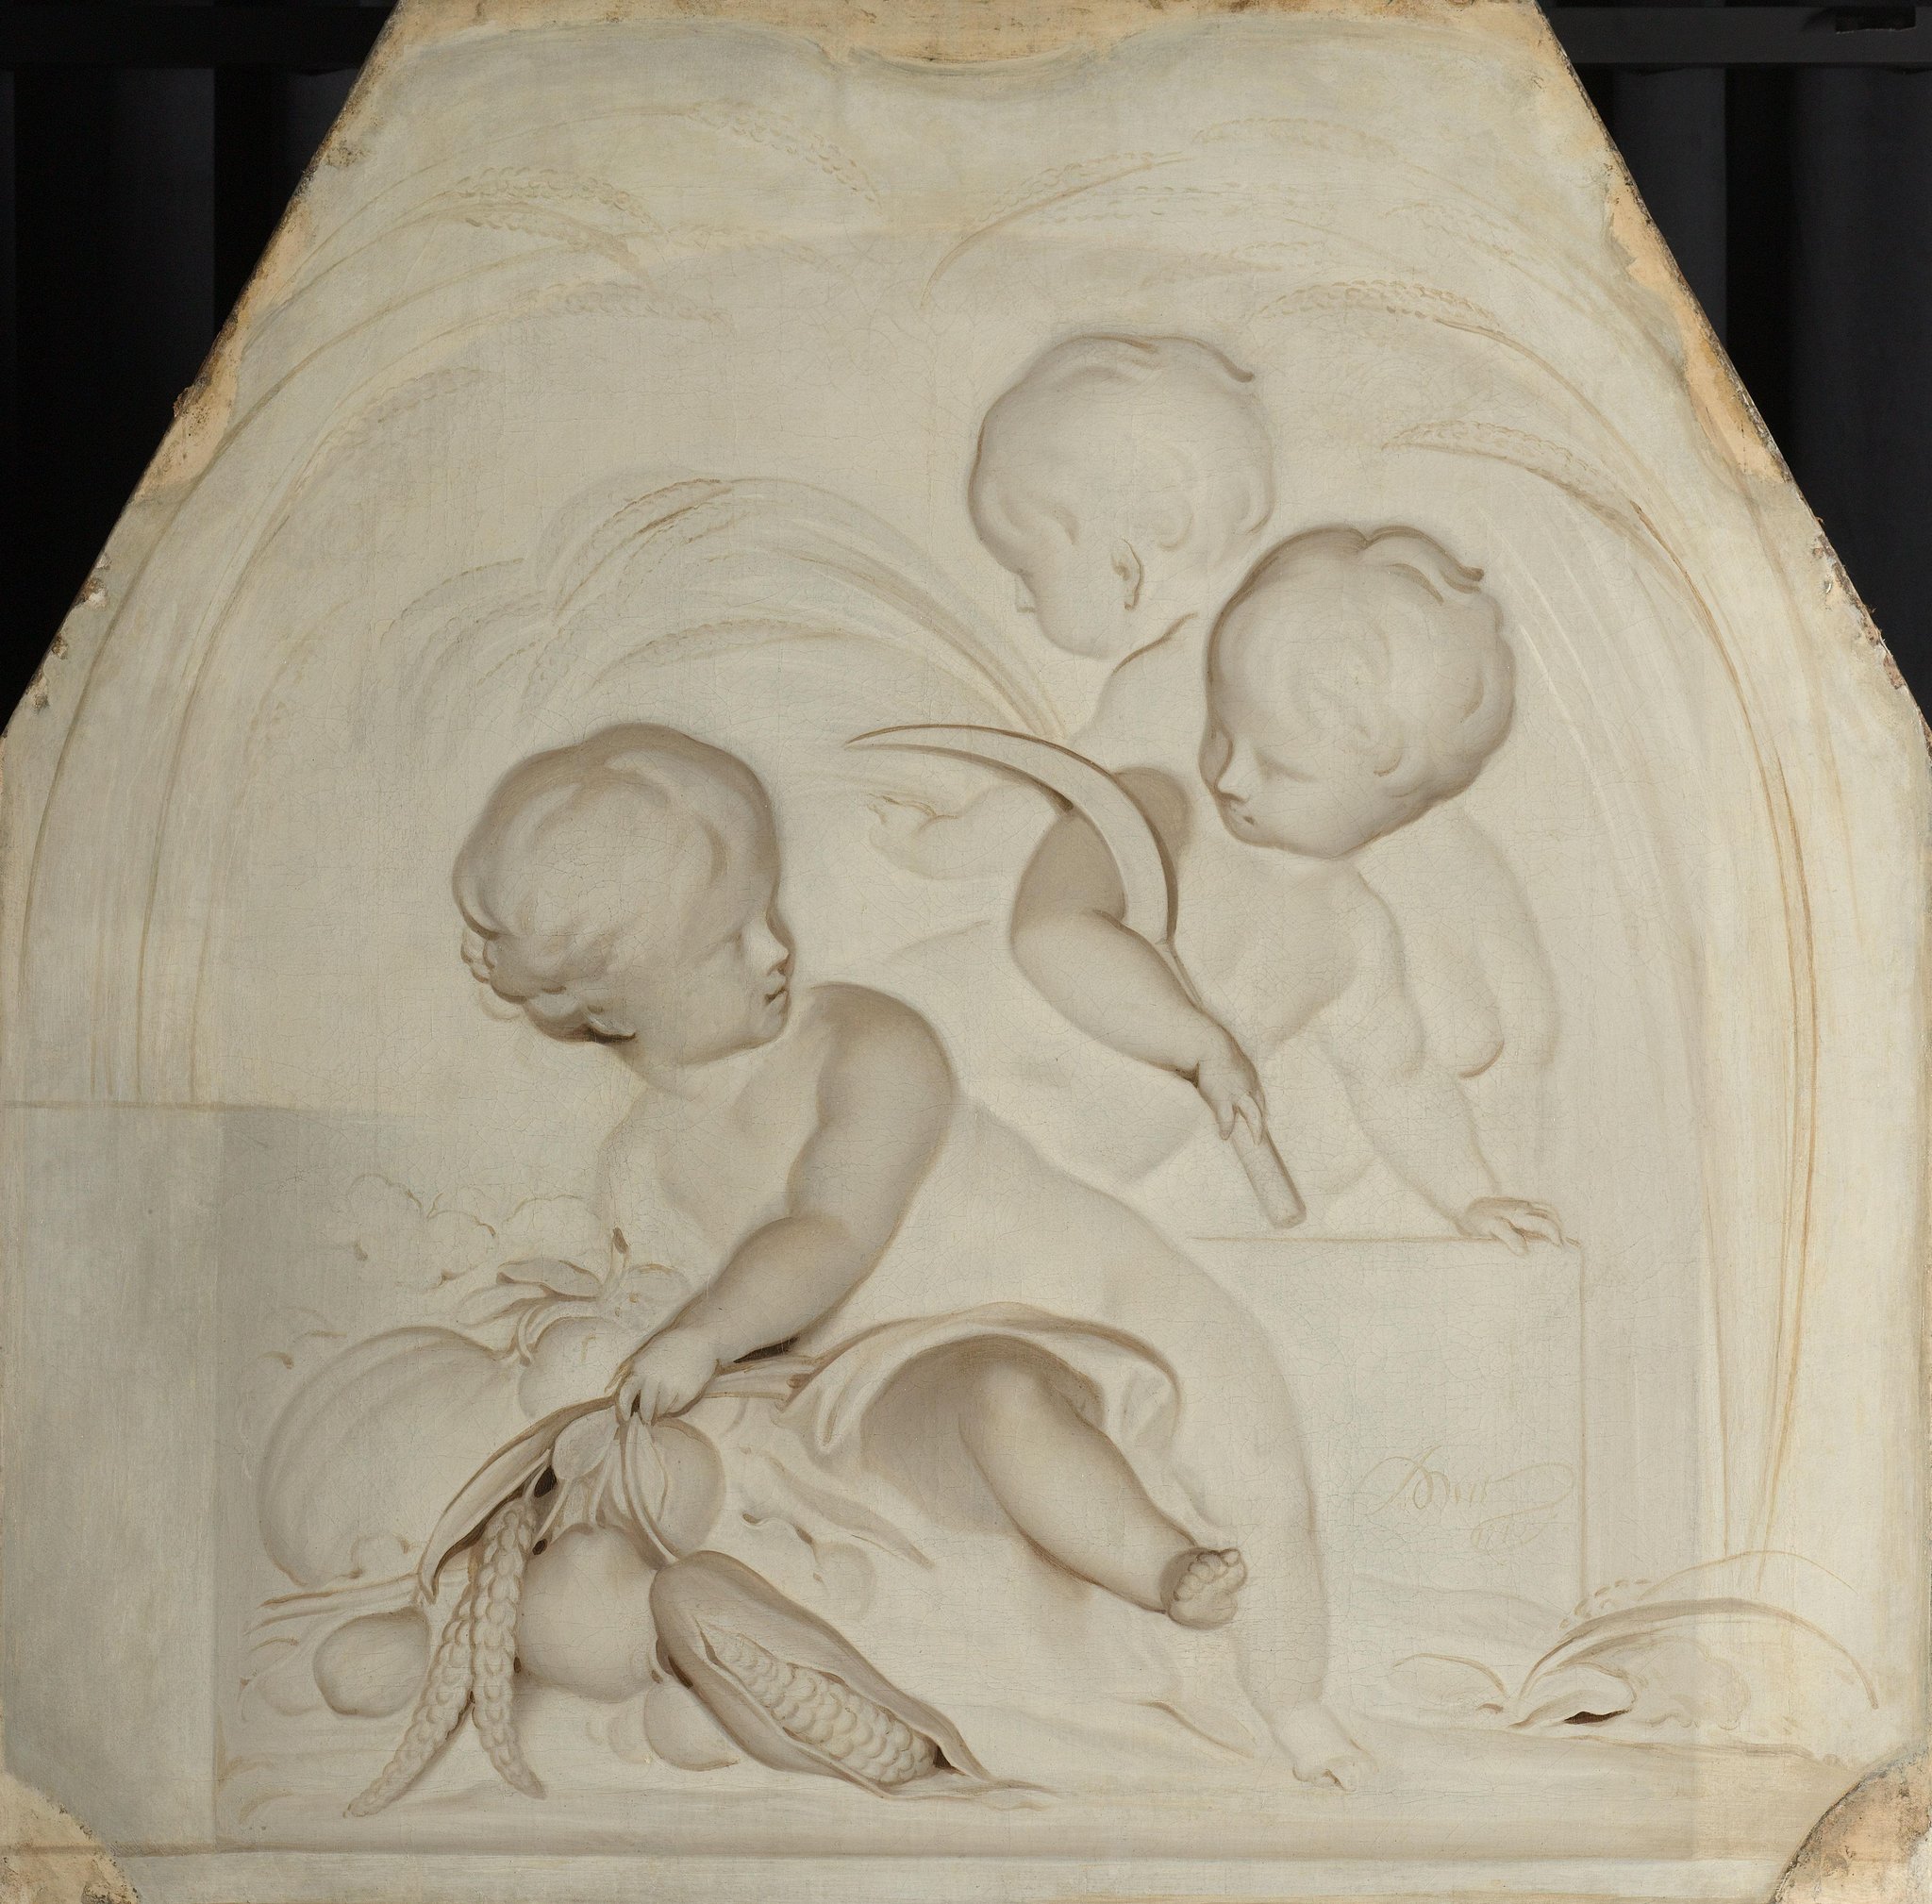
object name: overdoor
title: The Summer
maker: jacob de wit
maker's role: draughtsman, painter, print maker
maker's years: 1695-1754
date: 1740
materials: canvas, oil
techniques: grisaille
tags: harvest, summer, 'aestas'; 'estate' (ripa) (+ with scenes showing human occupations ~ seasons and months), cupids: 'amores', 'amoretti', 'putti'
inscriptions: signature and date, bottom right: ‘J. de Wit 1740’ J. de Wit 1740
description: The provenance of this overdoor is the same as that of Autumn and Winter, also on view in this gallery. Unfortunately, Spring has not come down to us, but it was probably round, like Winter. As in the other overdoors, three putti play with various attributes. The scythe, the cornstalks and the harvested fruit allude to summer.